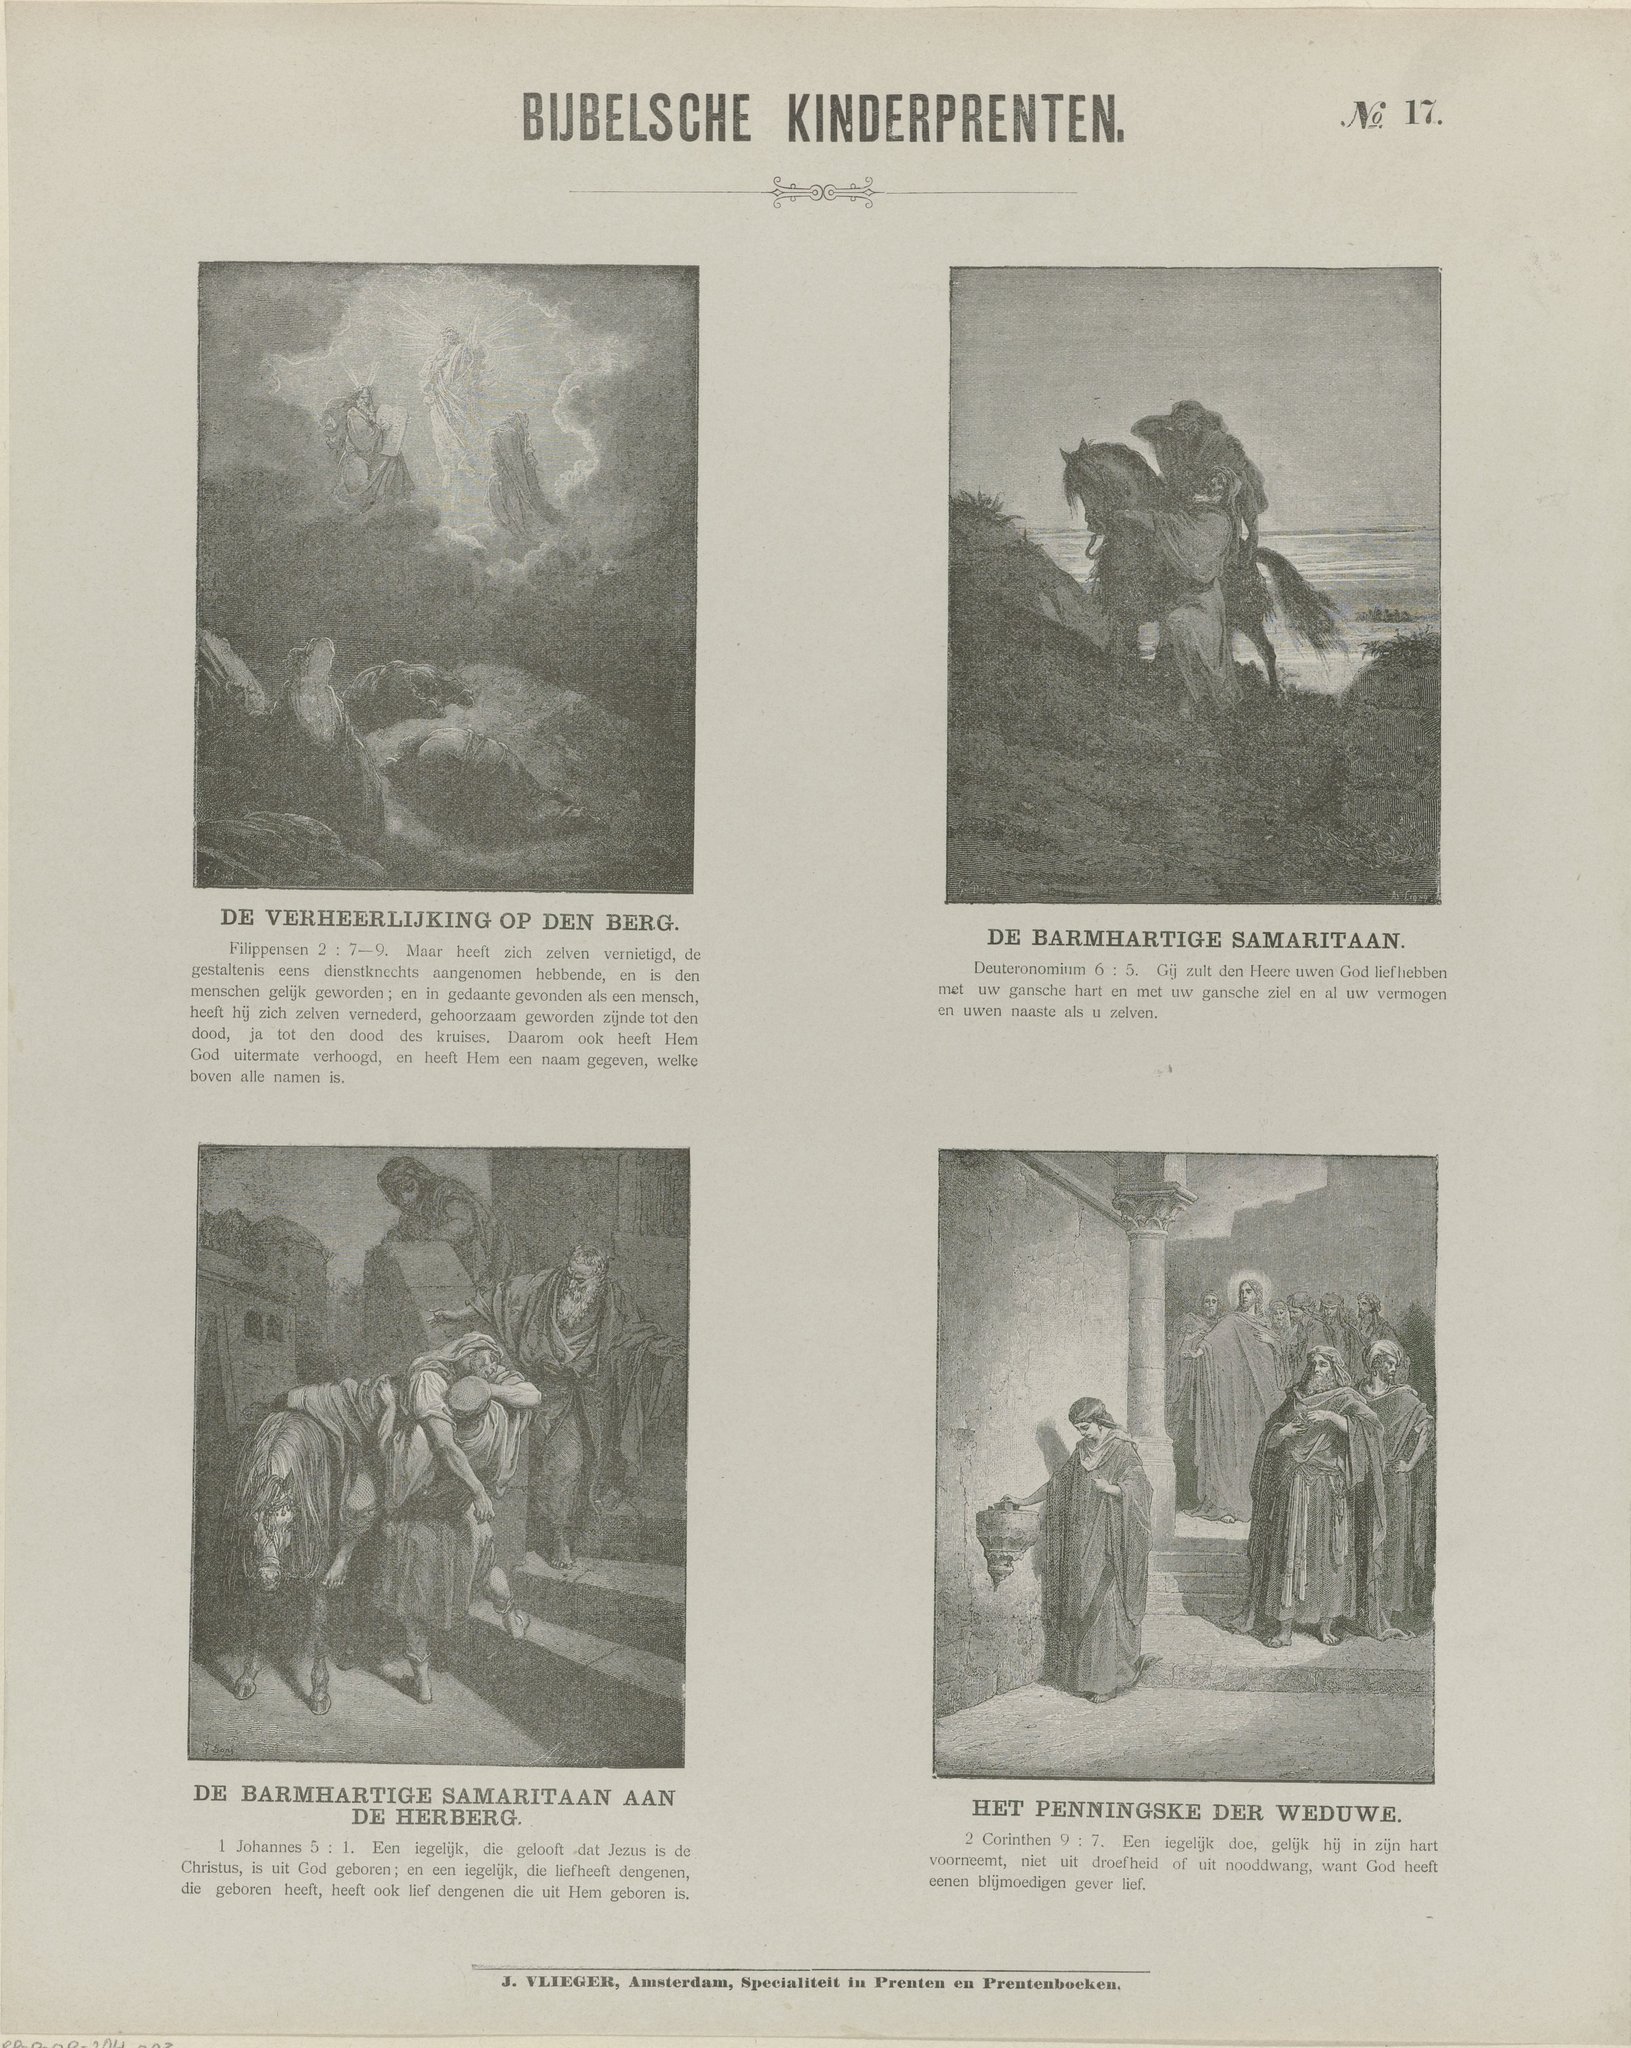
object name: popular print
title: Bijbelsche kinderprenten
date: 1869-1908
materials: paper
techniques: letterpress printing, photoaquatint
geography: amsterdam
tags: the good samaritan (luke 10:30-37), the widow's mite: christ draws the disciples' attention to a woman who puts a few coins in the temple's money chest (mark 12:41-44; luke 21:1-4) (+ angel(s)), the transfiguration: moses and elijah appear on either side of christ on mount tabor (matthew 17:1-13; mark 9:2-13; luke 9:28-36), new testament, the samaritan and the wounded traveller arrive at the inn; the traveller is cared for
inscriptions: collector's mark: Lugt 2760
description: Blad met 4 voorstellingen van verhalen uit het Nieuwe Testament. De verheerlijking op de berg, de barmhartige Samaritaan vervoert de gewonde reiziger op zijn paard, de barmhartige Samaritaan arriveert met de gewonde reiziger bij een herberg en een arme weduwe die geld geeft (het penningske van de weduwe). Onder elke afbeelding een Bijbeltekst. Genummerd rechtsboven: No. 17.